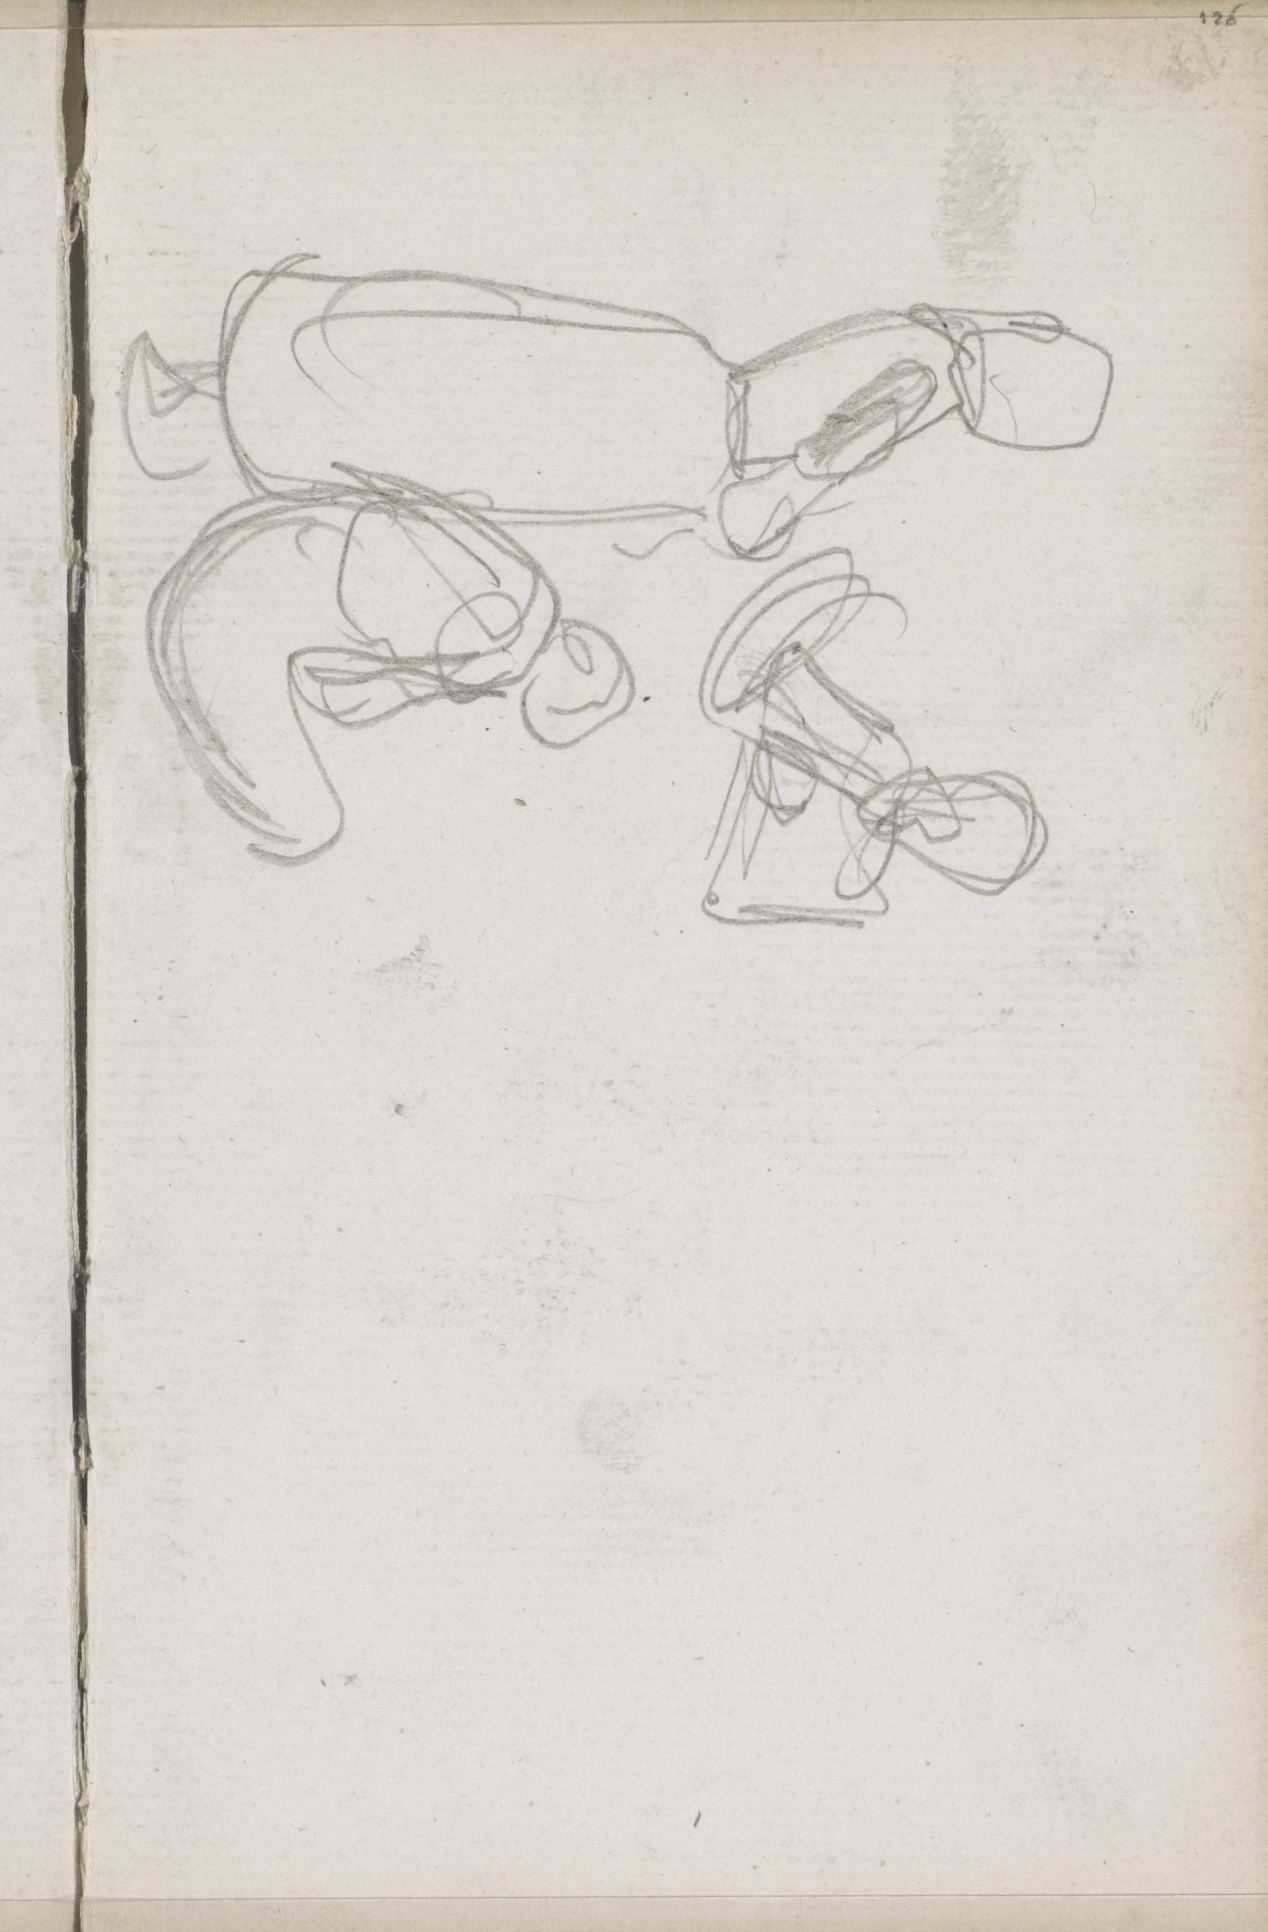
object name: sketchbook leaf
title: Boerinnen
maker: george hendrik breitner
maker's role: draughtsman, painter, print maker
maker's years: 1857-1923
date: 1884-1886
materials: paper, pencil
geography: drenthe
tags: farmers - aa - female farmer, farmer's wife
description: Pagina 126 uit een schetsboek met 67 bladen vervaardigd in Drenthe.